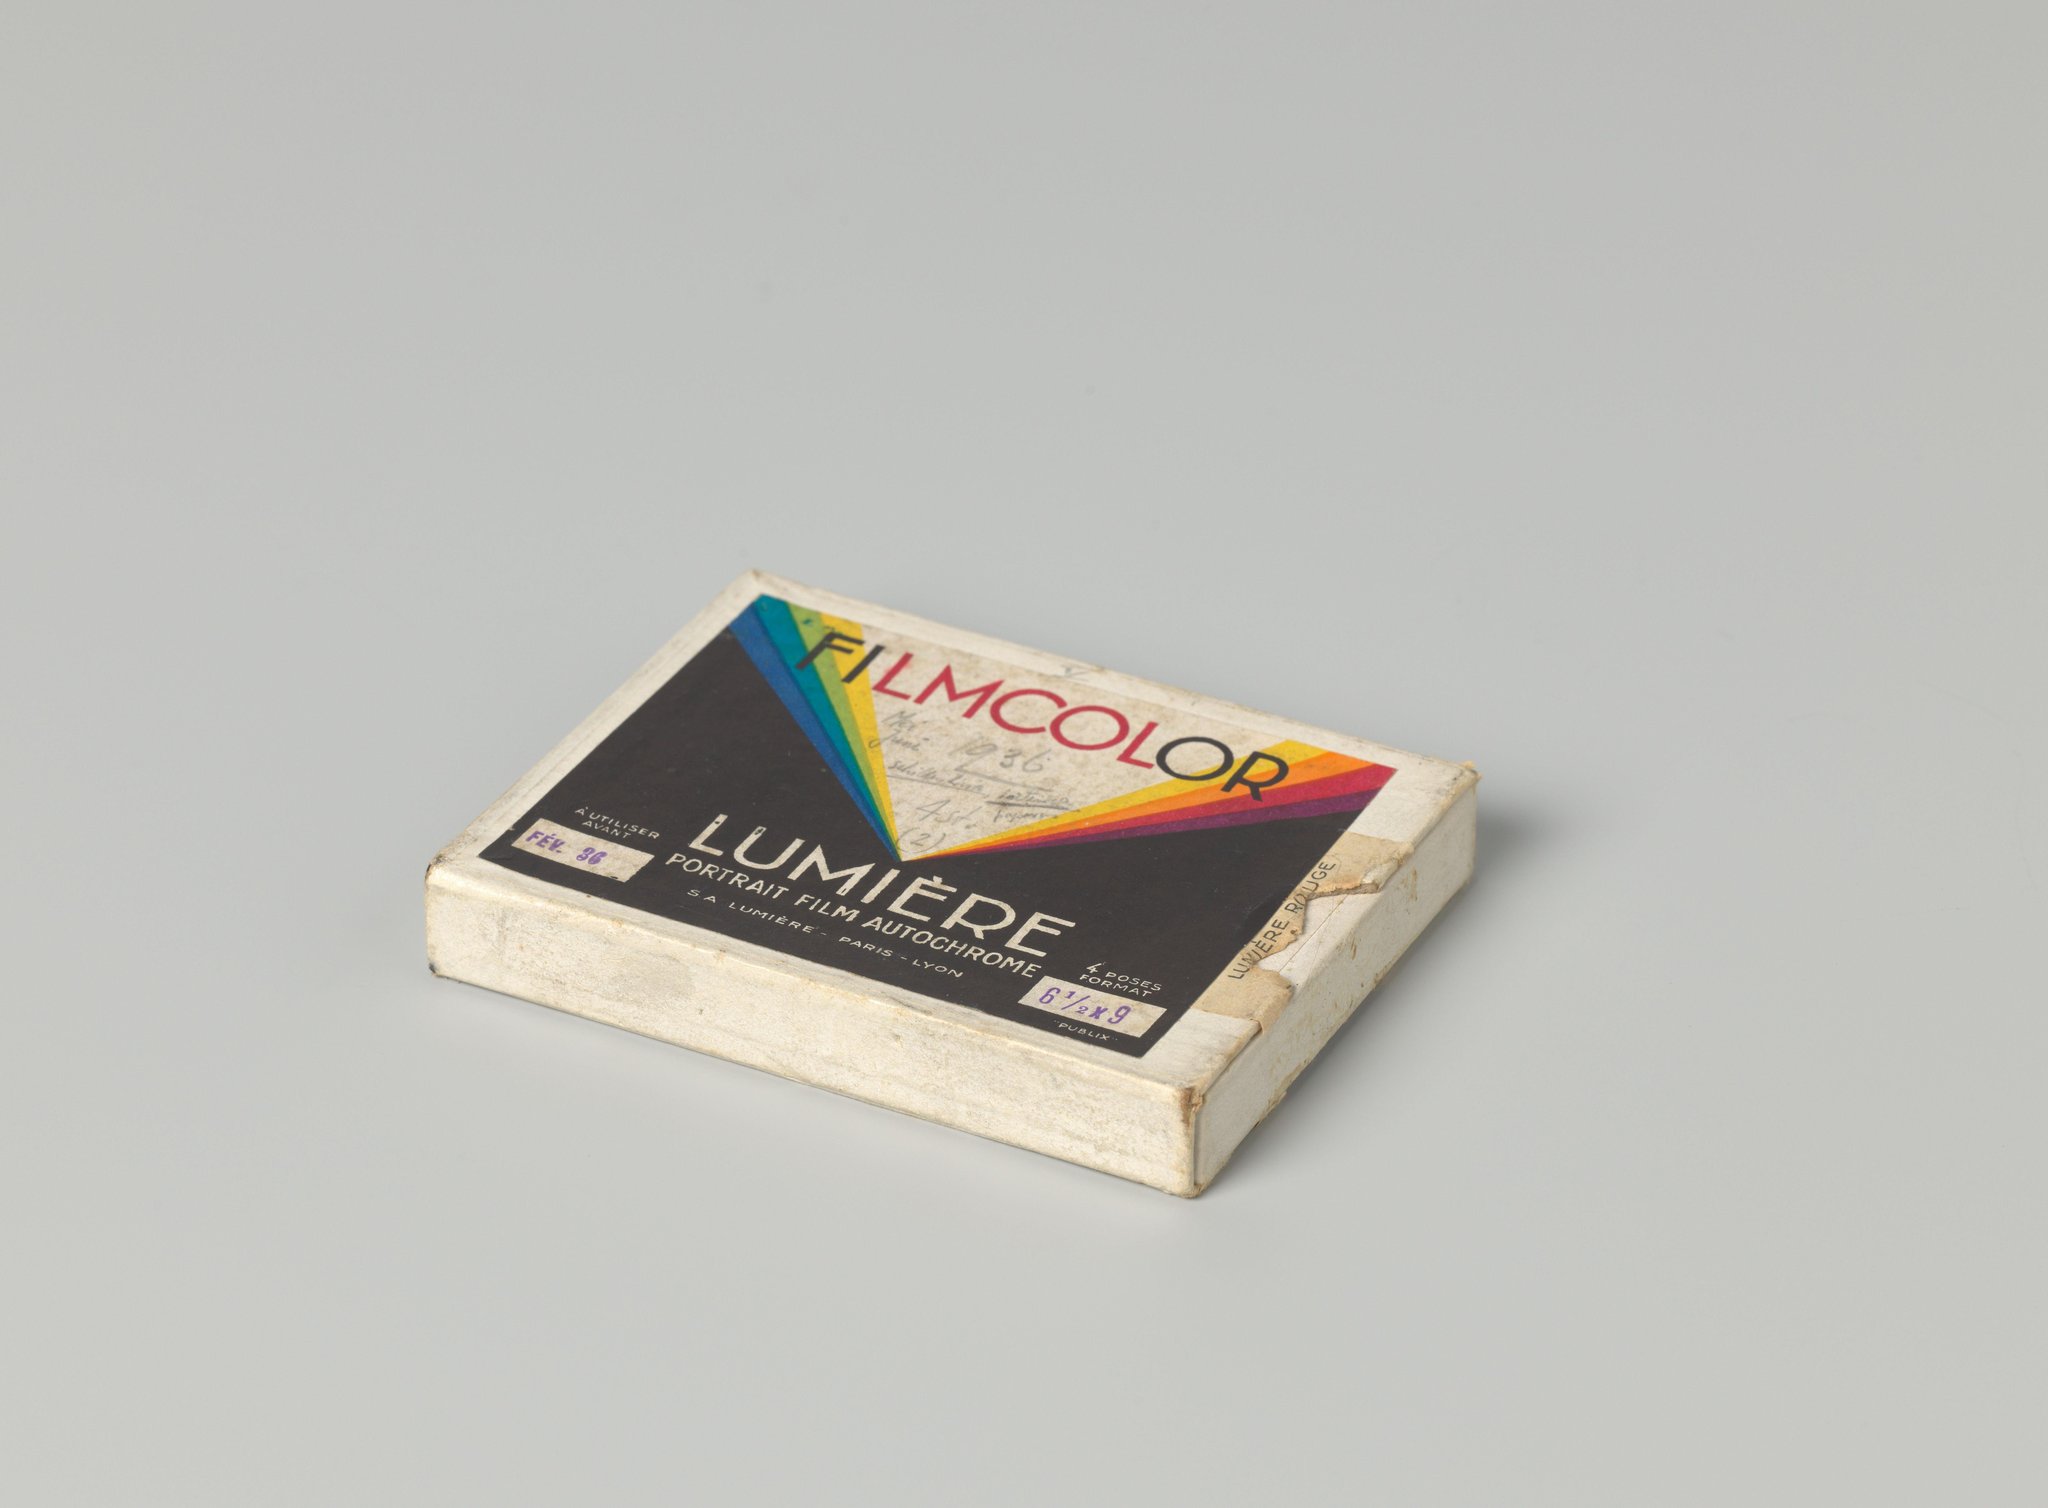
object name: box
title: Doos voor autochromes van Lumière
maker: lumière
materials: cardboard, paper, tape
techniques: printing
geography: france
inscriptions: date: ‘À UTILISER/ AVANT/ FÉV. 36’, inscription: ‘Mei/ Juni/ 1936/ [...]/ 4st/ (2)’